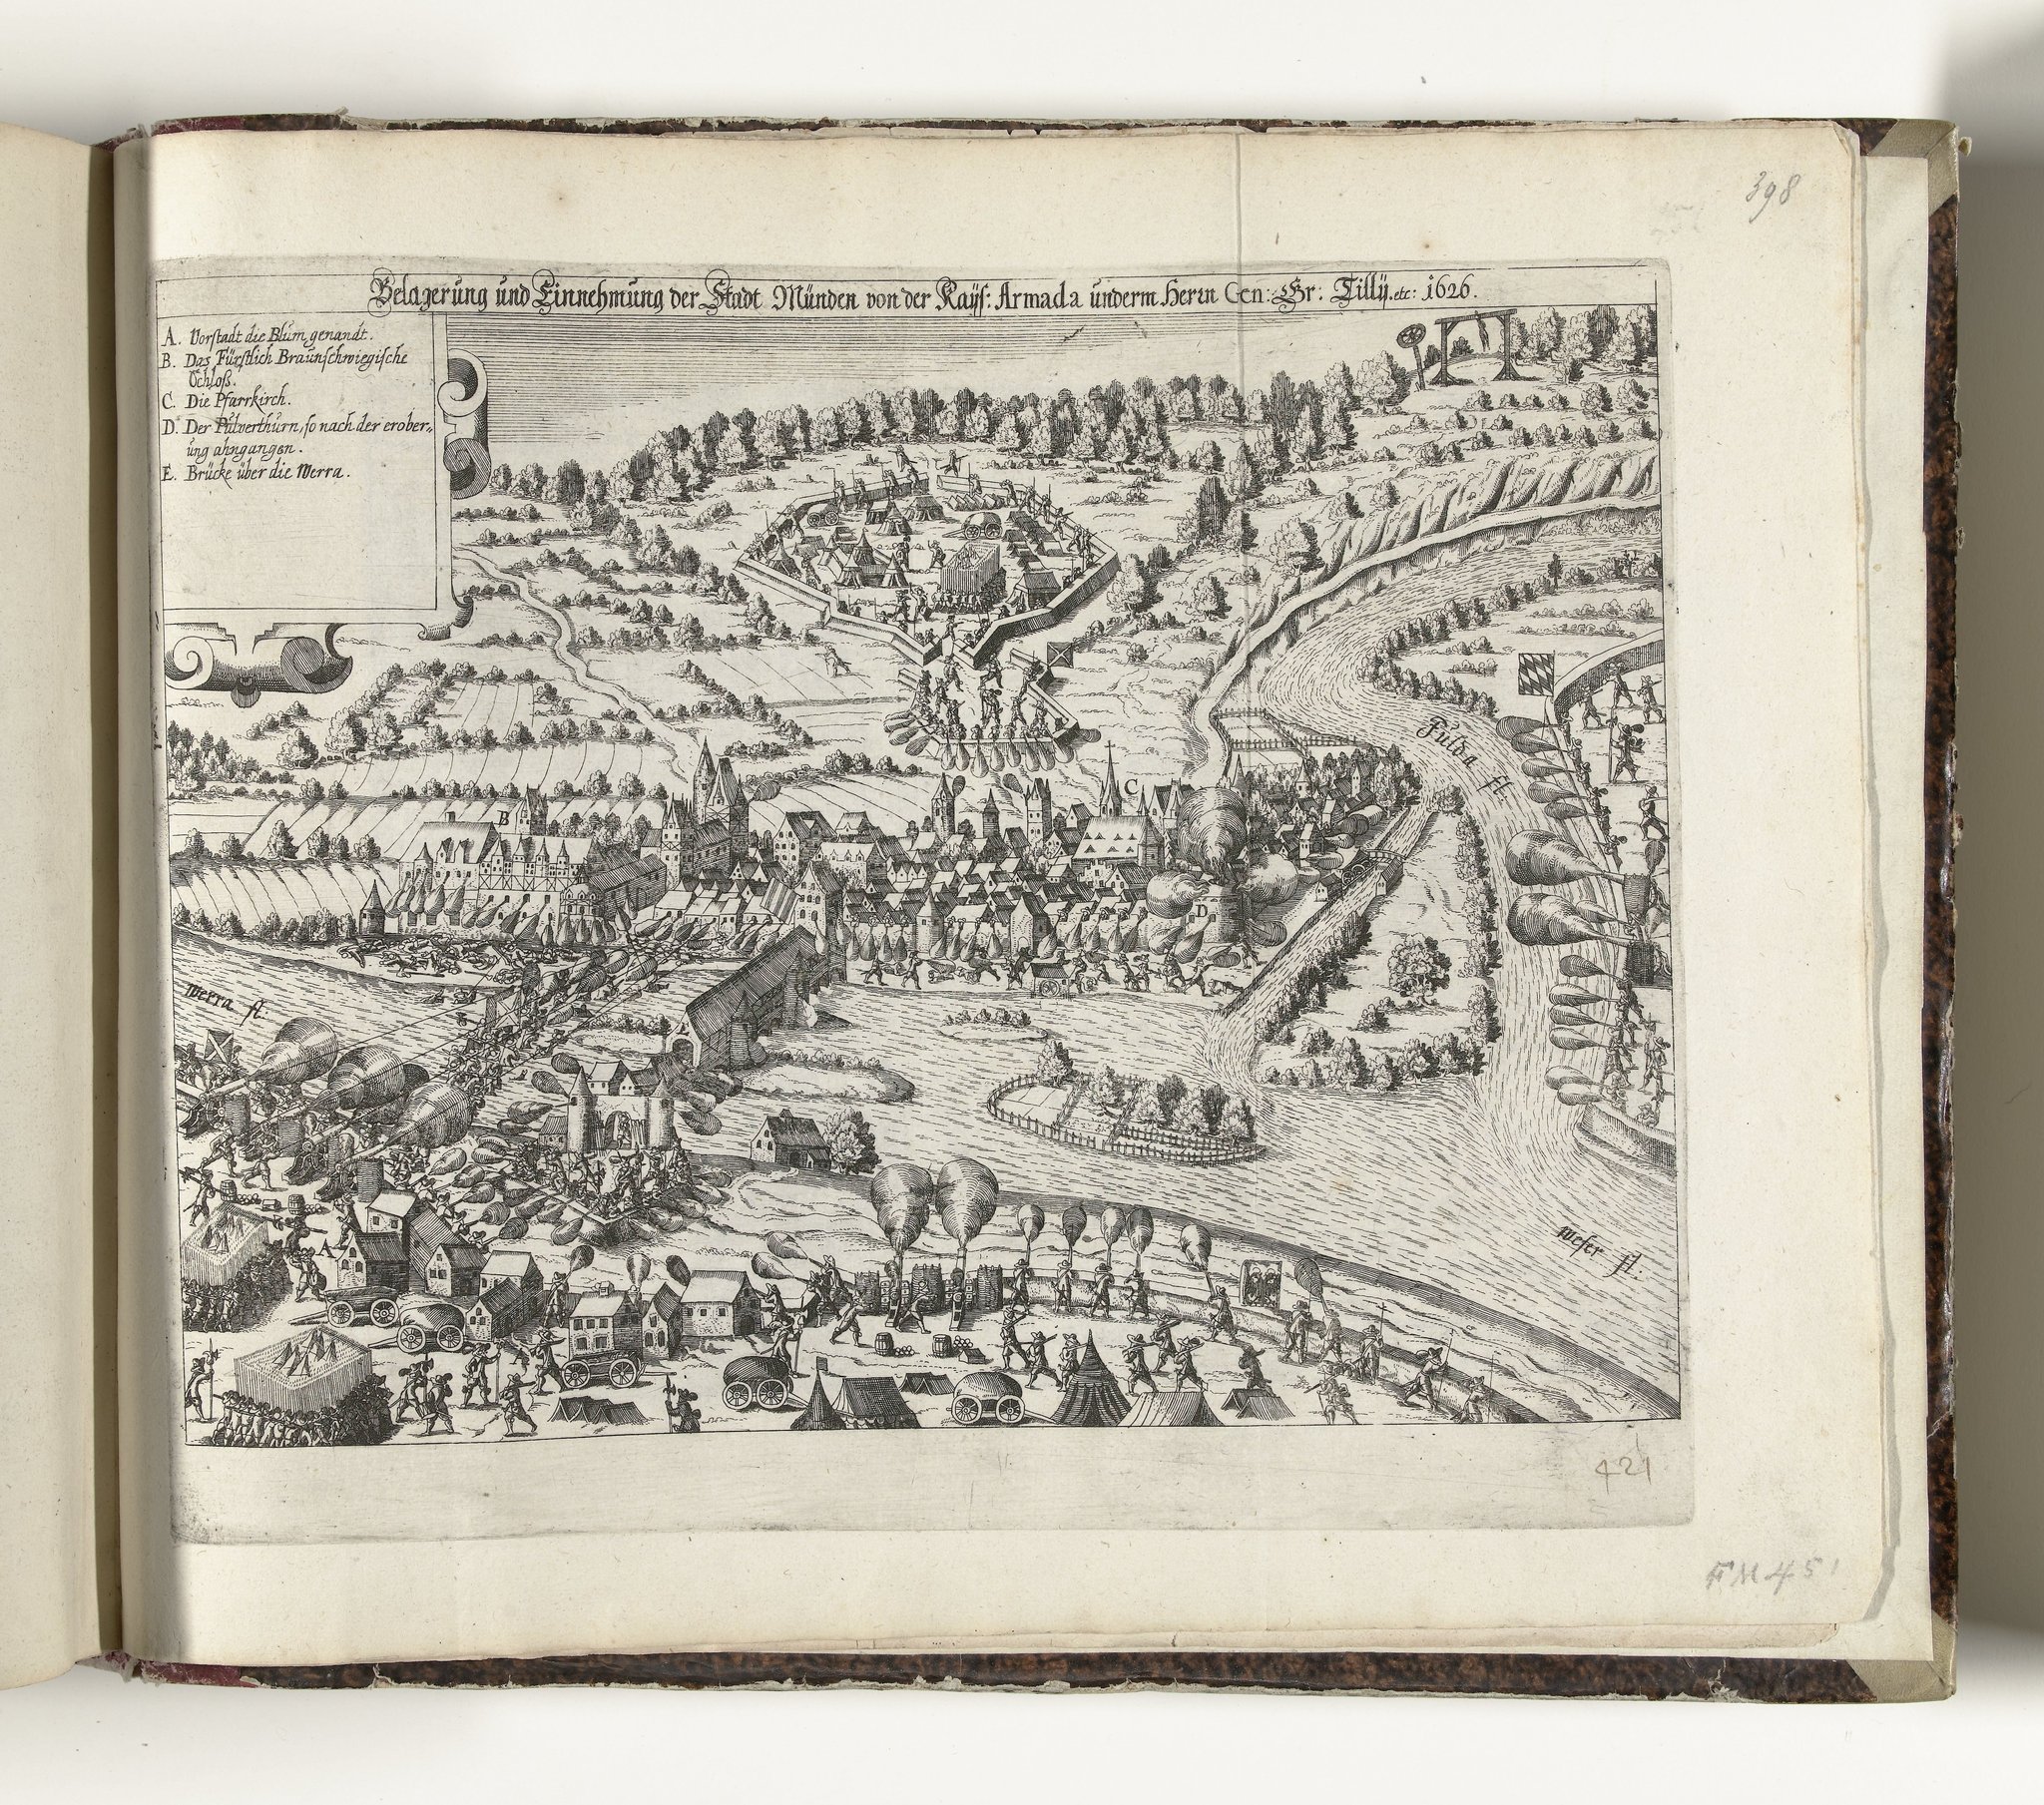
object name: print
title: Beleg en inname van Münden door Tilly, 1626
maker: frans hogenberg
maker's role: print maker, publisher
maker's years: 1538-1590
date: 1626-1628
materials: paper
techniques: etching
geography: cologne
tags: siege, position war, capture of city (after the siege)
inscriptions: inscription: ‘421’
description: Beleg en inname van Hannoversch-Münden door Tilly, augustus 1626. Zonder onderschrift. Linksboven een legenda A-E. Rechtsonder met pen genummerd: 421. De prent maakt deel uit van een album.